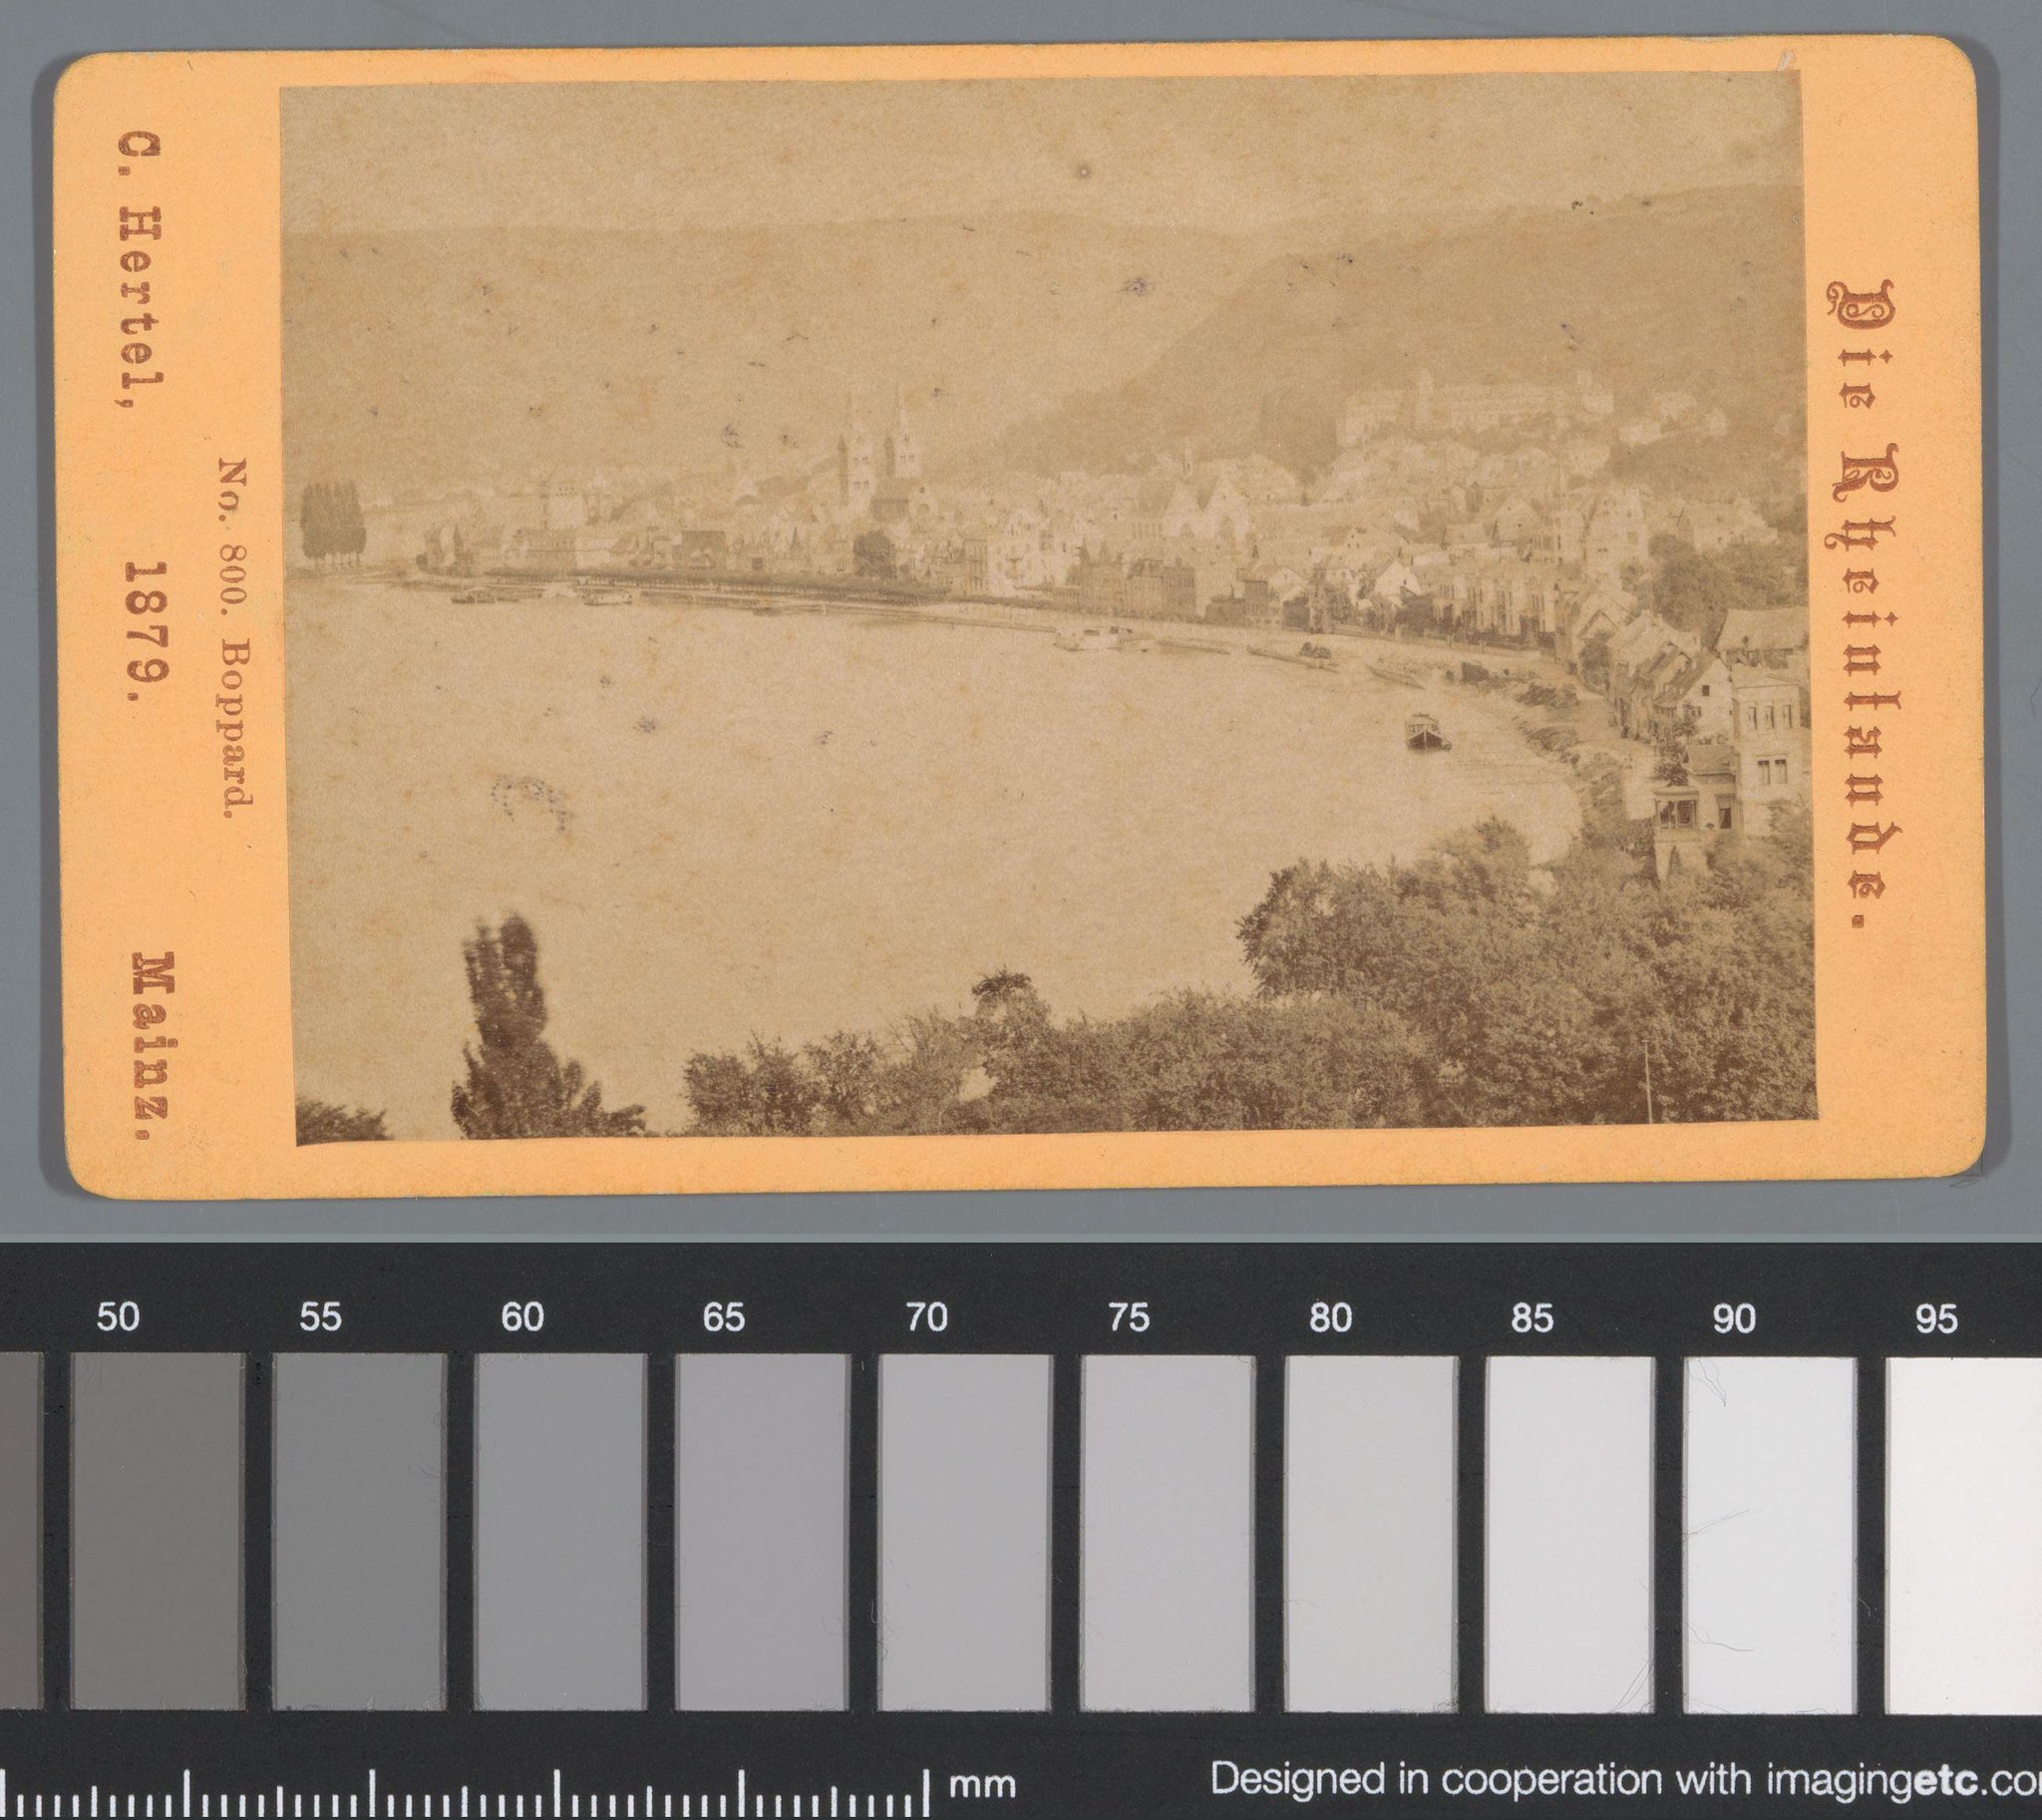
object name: carte de visite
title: Gezicht op Boppard aan de Rijn, Duitsland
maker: carl hertel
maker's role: publisher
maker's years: 1832-1906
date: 1879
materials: cardboard, paper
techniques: albumen print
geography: boppard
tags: prospect of village, silhouette of village, river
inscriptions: number: ‘No. 800.’